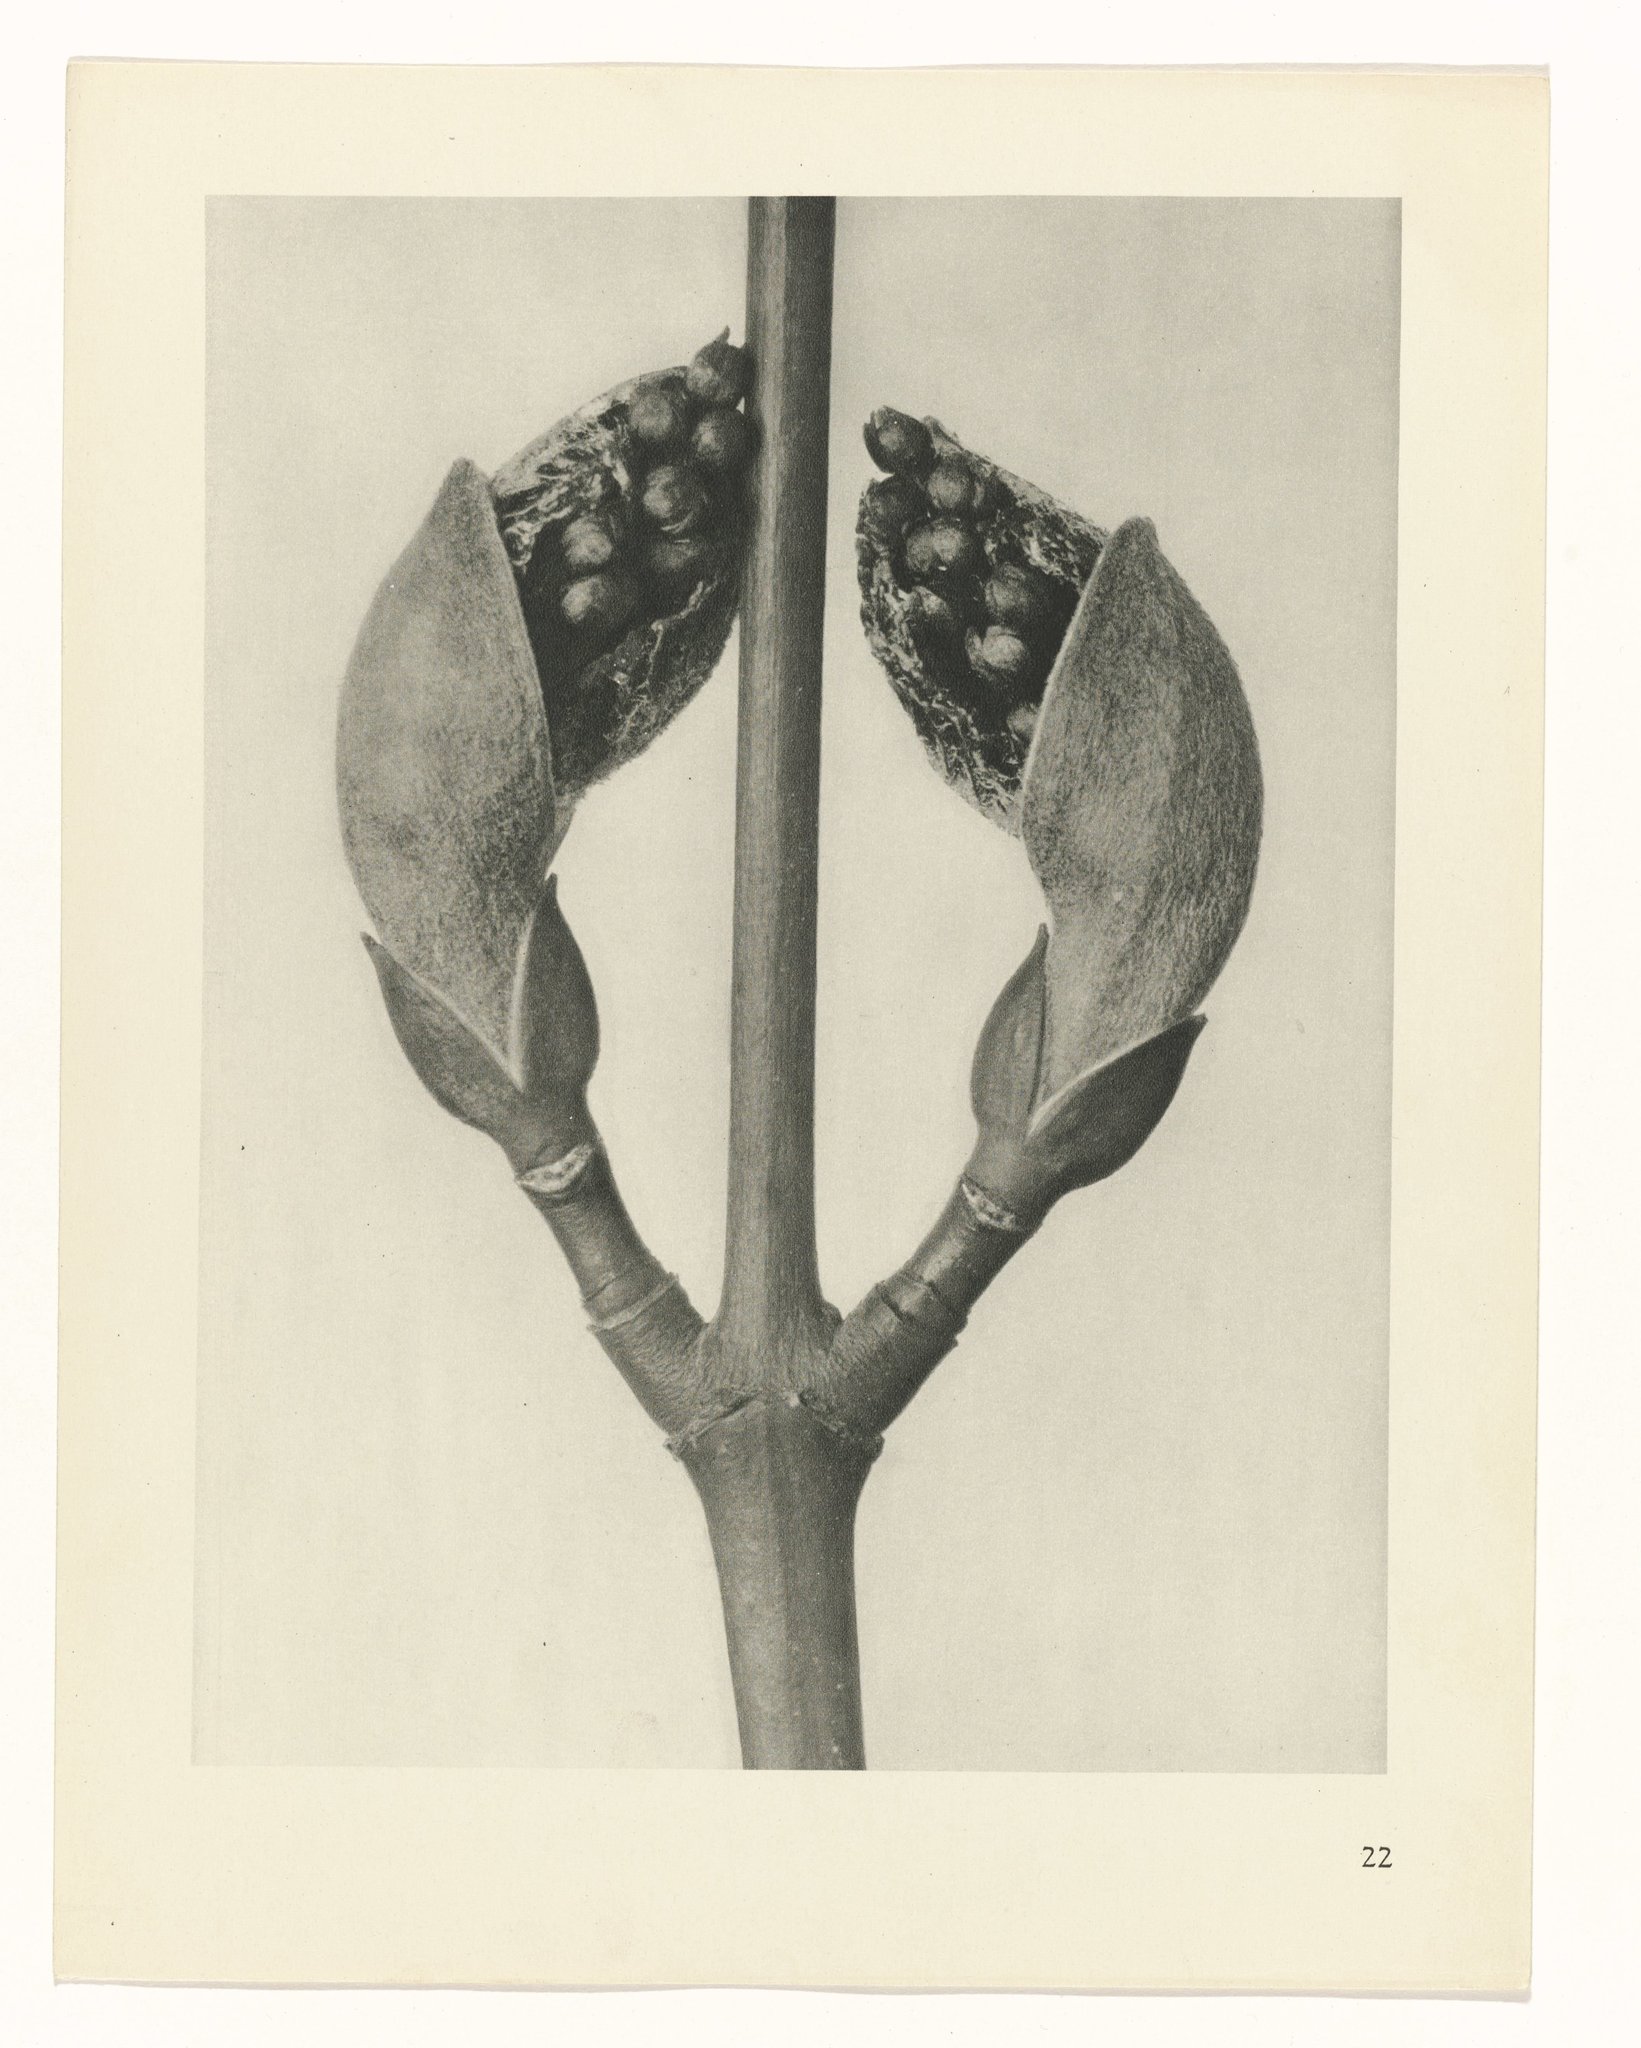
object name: photograph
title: Plantstudie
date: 1928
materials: ink, paper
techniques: rotogravure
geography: berlin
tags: plants (in general)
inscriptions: number: ‘22’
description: facher Vergrößerung. Afkomstig uit losbladige uitgave.